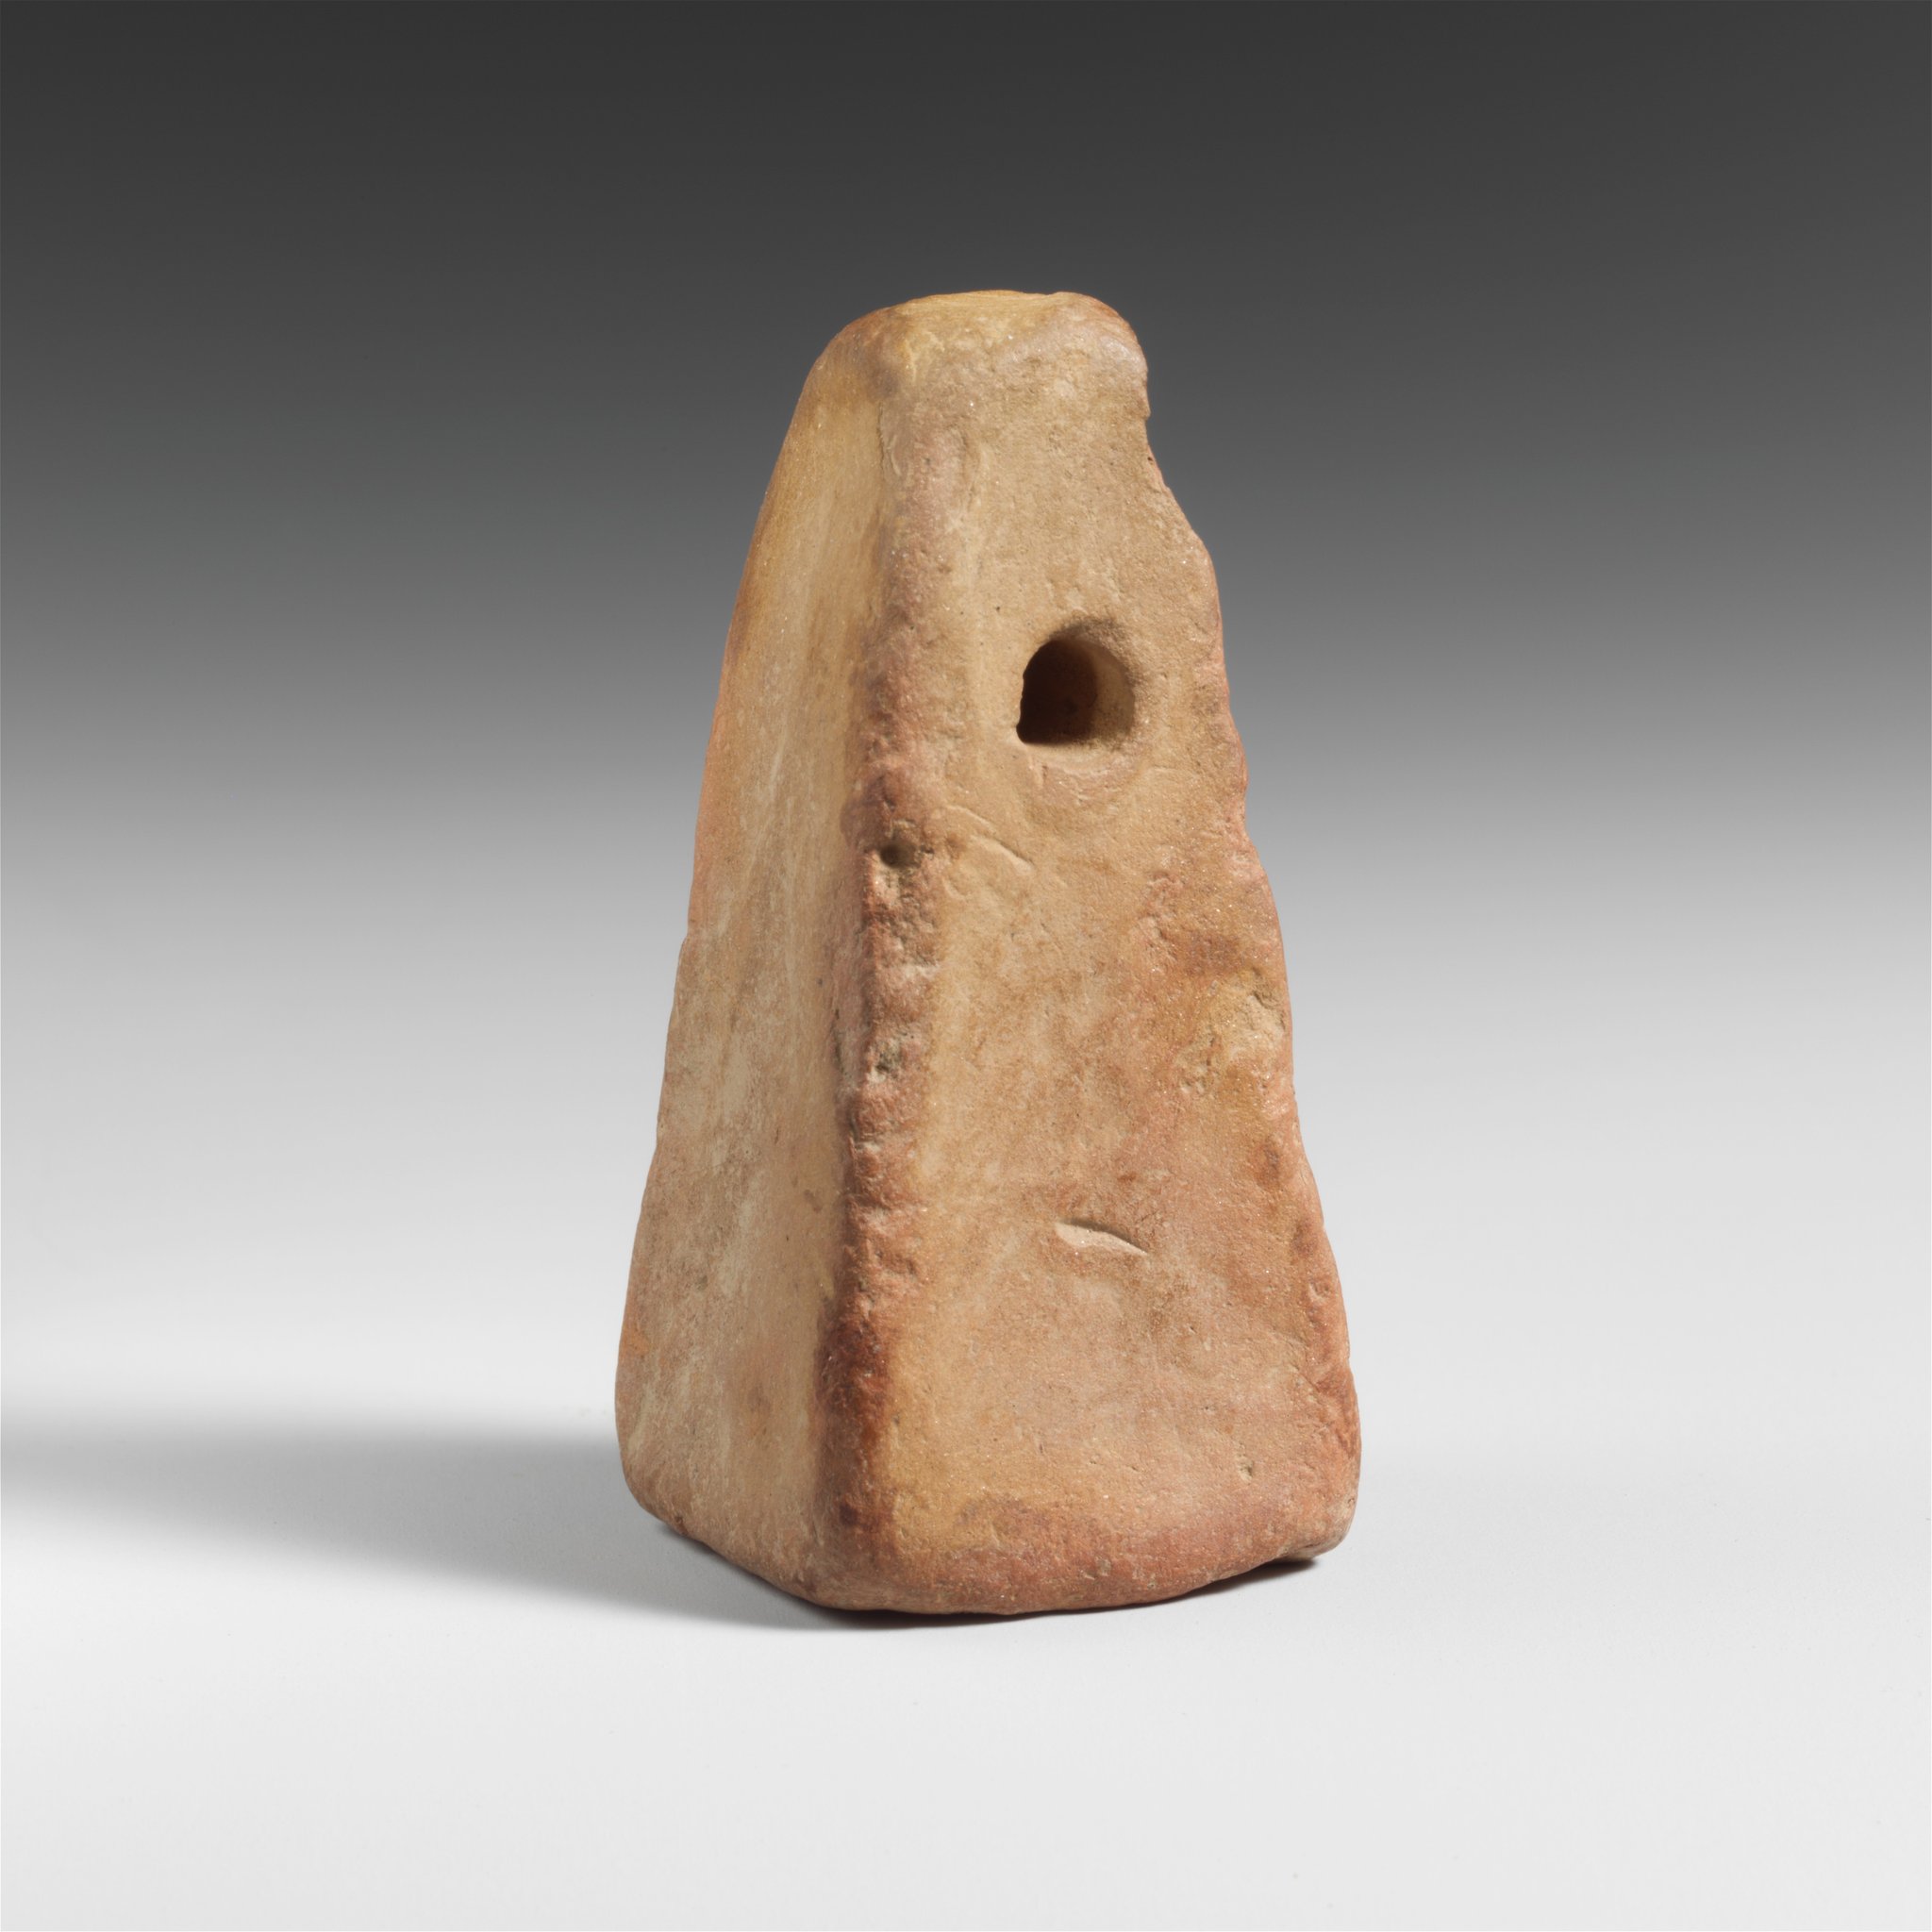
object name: loom weight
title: Terracotta loom weight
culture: lydian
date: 501-600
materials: terracotta